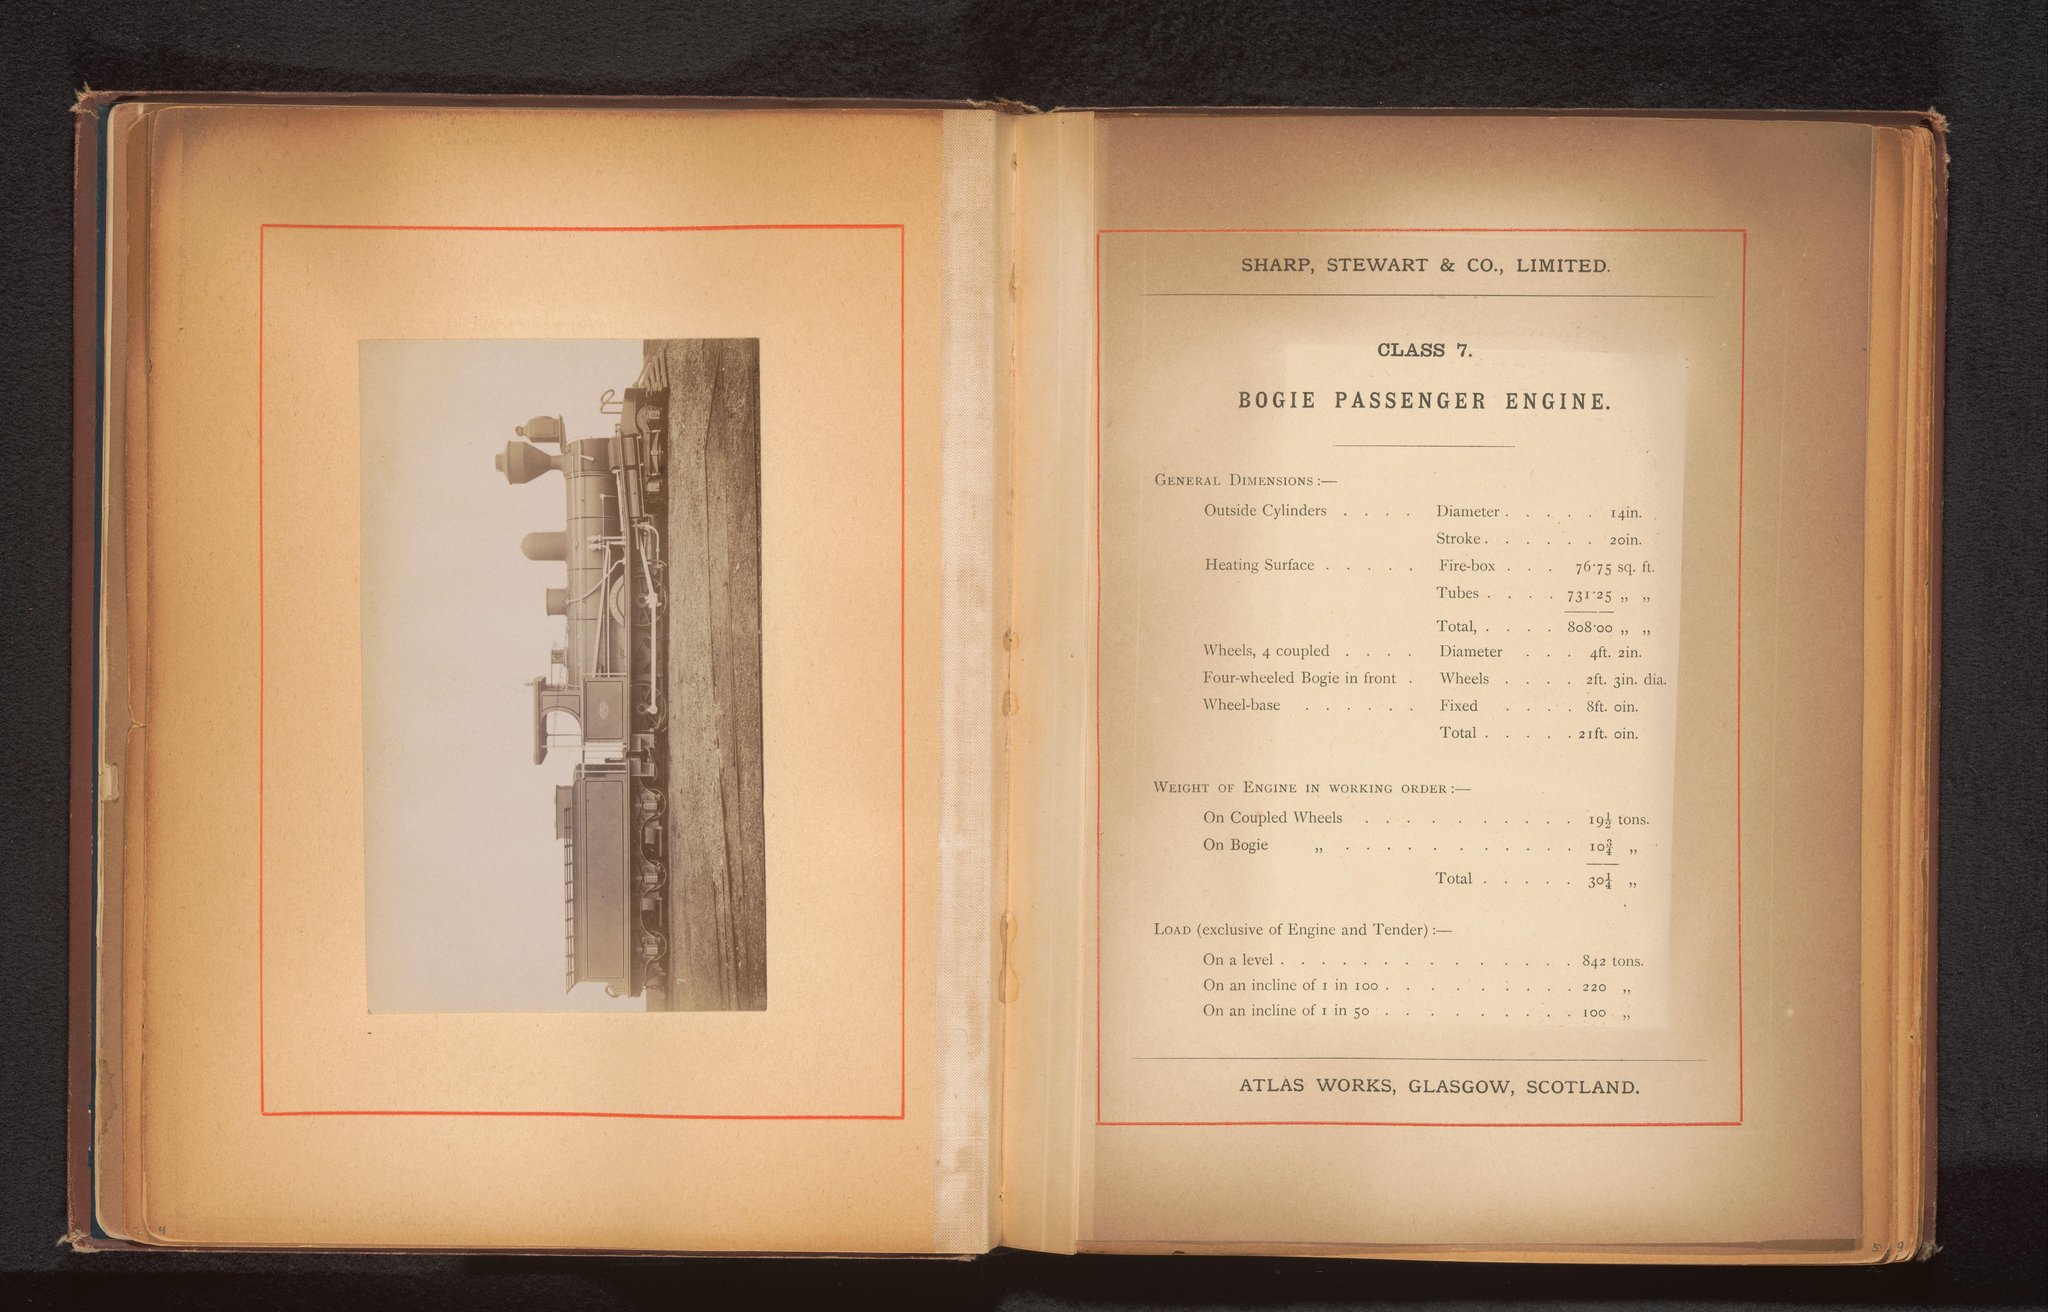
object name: photograph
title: Stoomlocomotief voor personenvervoer gemaakt door Sharp, Stewart and Company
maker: Anonymous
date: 1874-1884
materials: photographic support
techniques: albumen print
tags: steam locomotive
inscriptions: inscription: ‘Class 7. Bogie passenger engine.’, number: ‘7.’